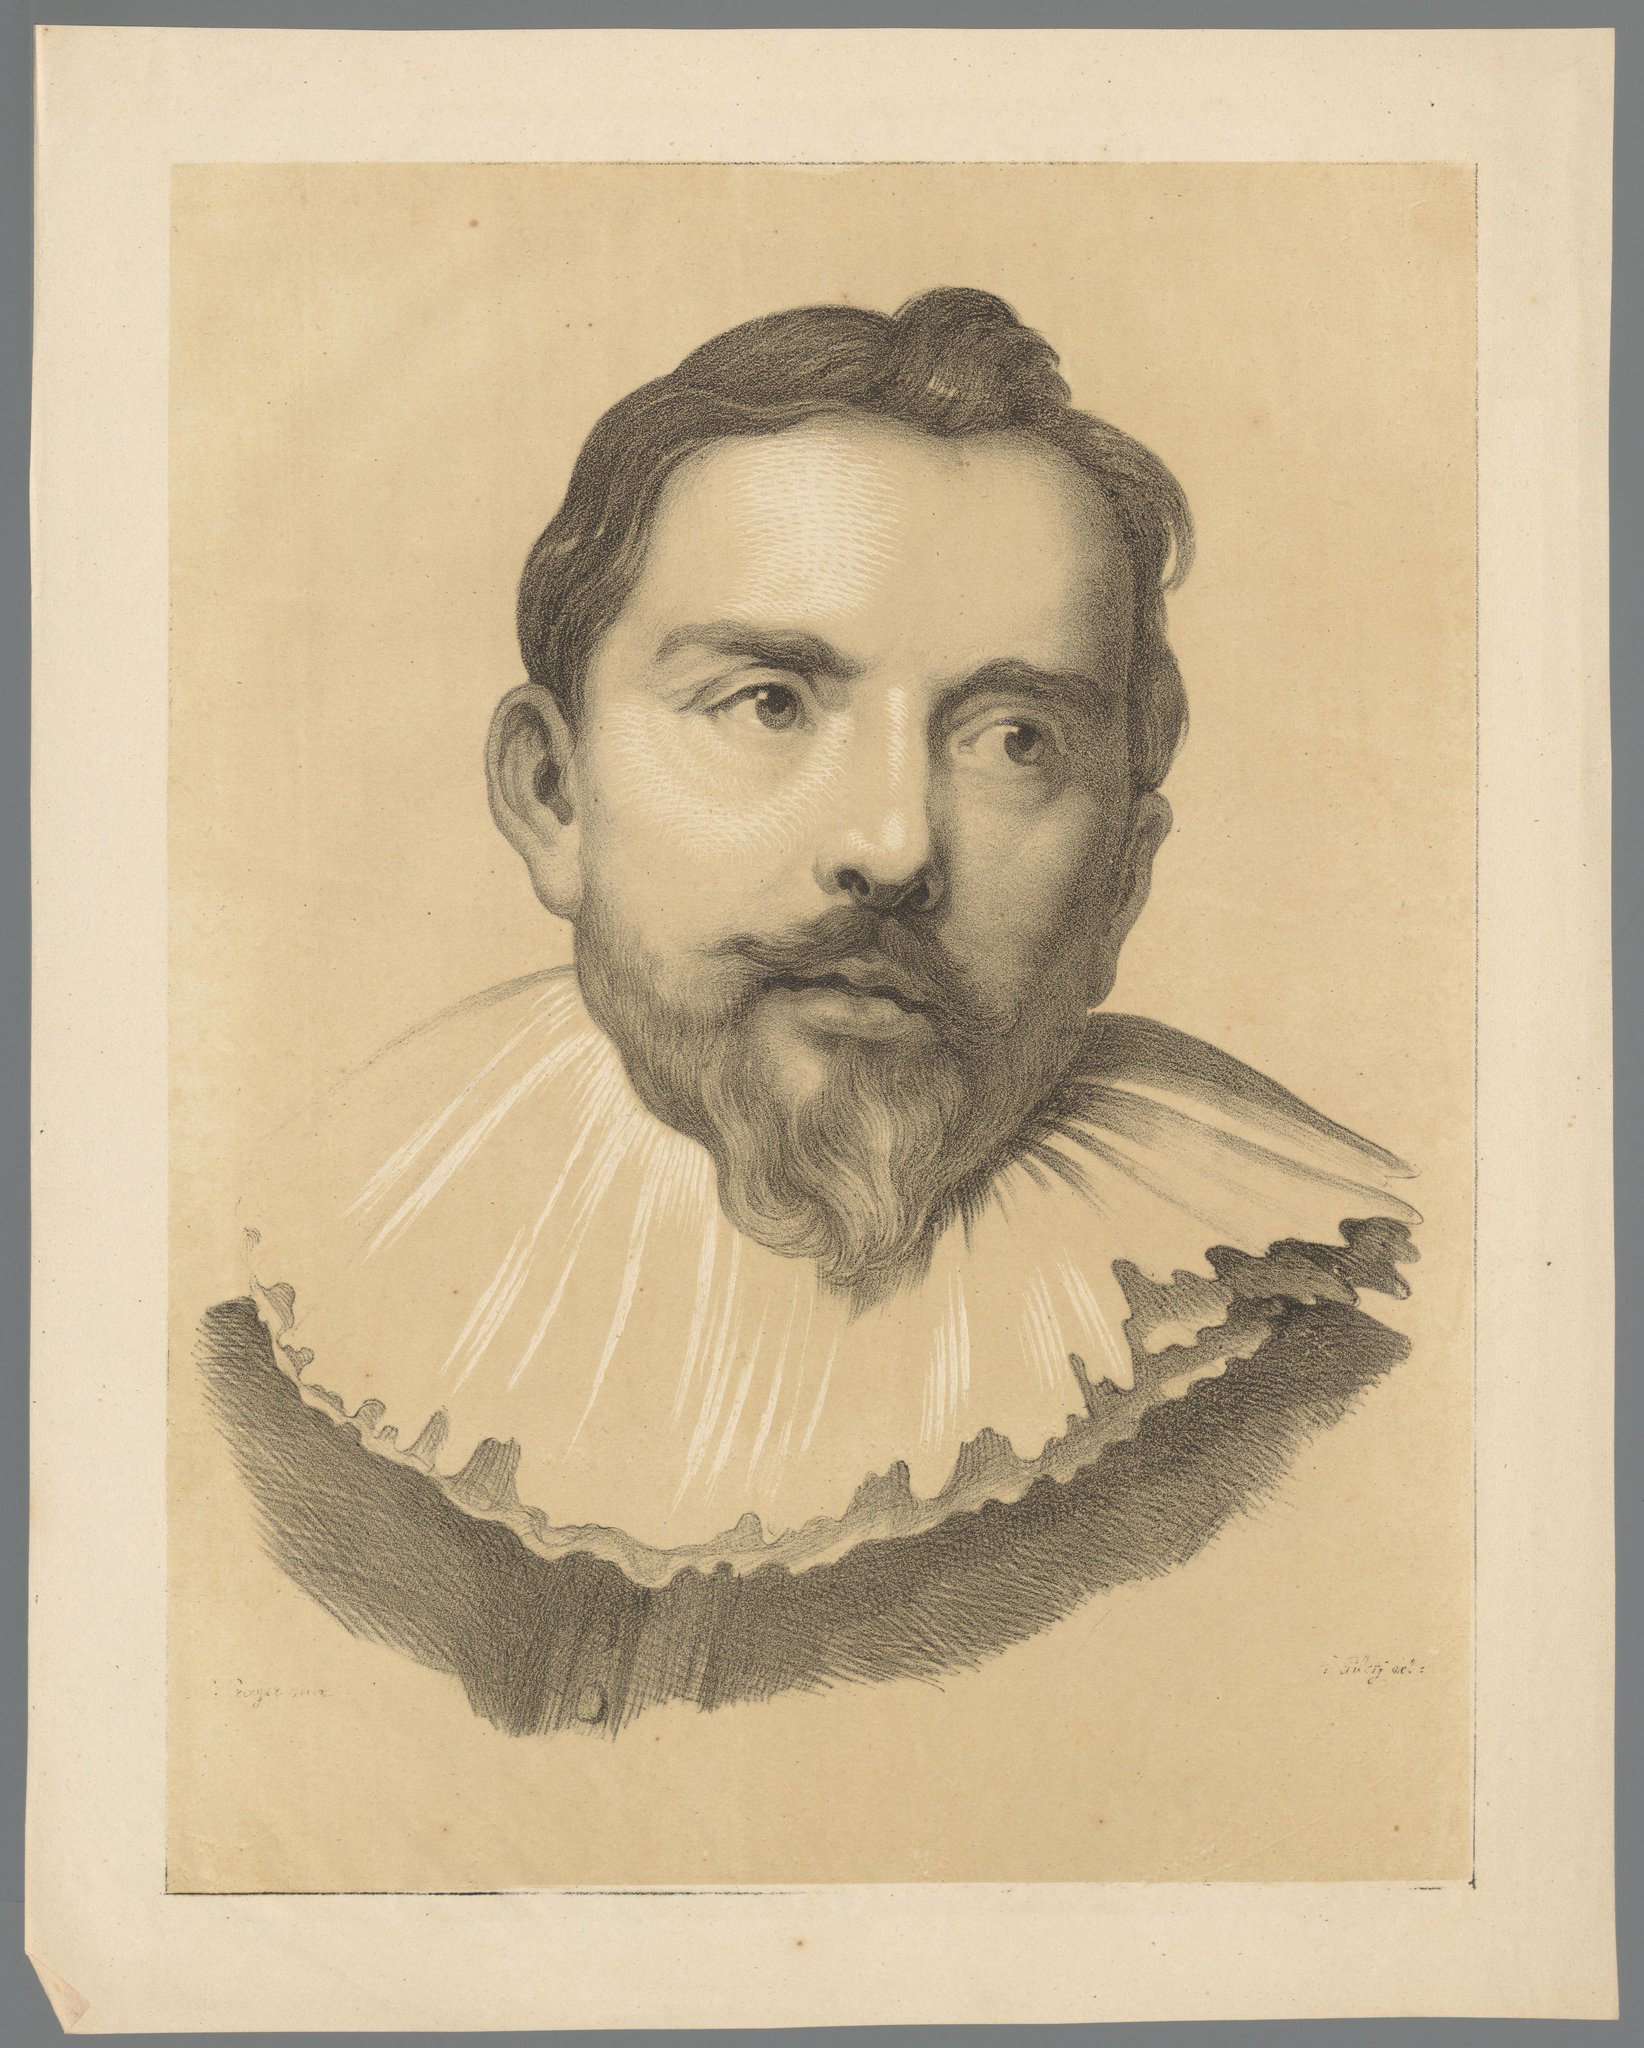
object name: print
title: Portret van Gaspar de Crayer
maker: gaspar de crayer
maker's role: draughtsman, print maker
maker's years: 1584-1669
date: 1820-1850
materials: paper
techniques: tone lithography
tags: antwerp, ghent, print maker, draughtsman, gaspar de crayer, adult man, historical persons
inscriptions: collector's mark: Lugt 2228